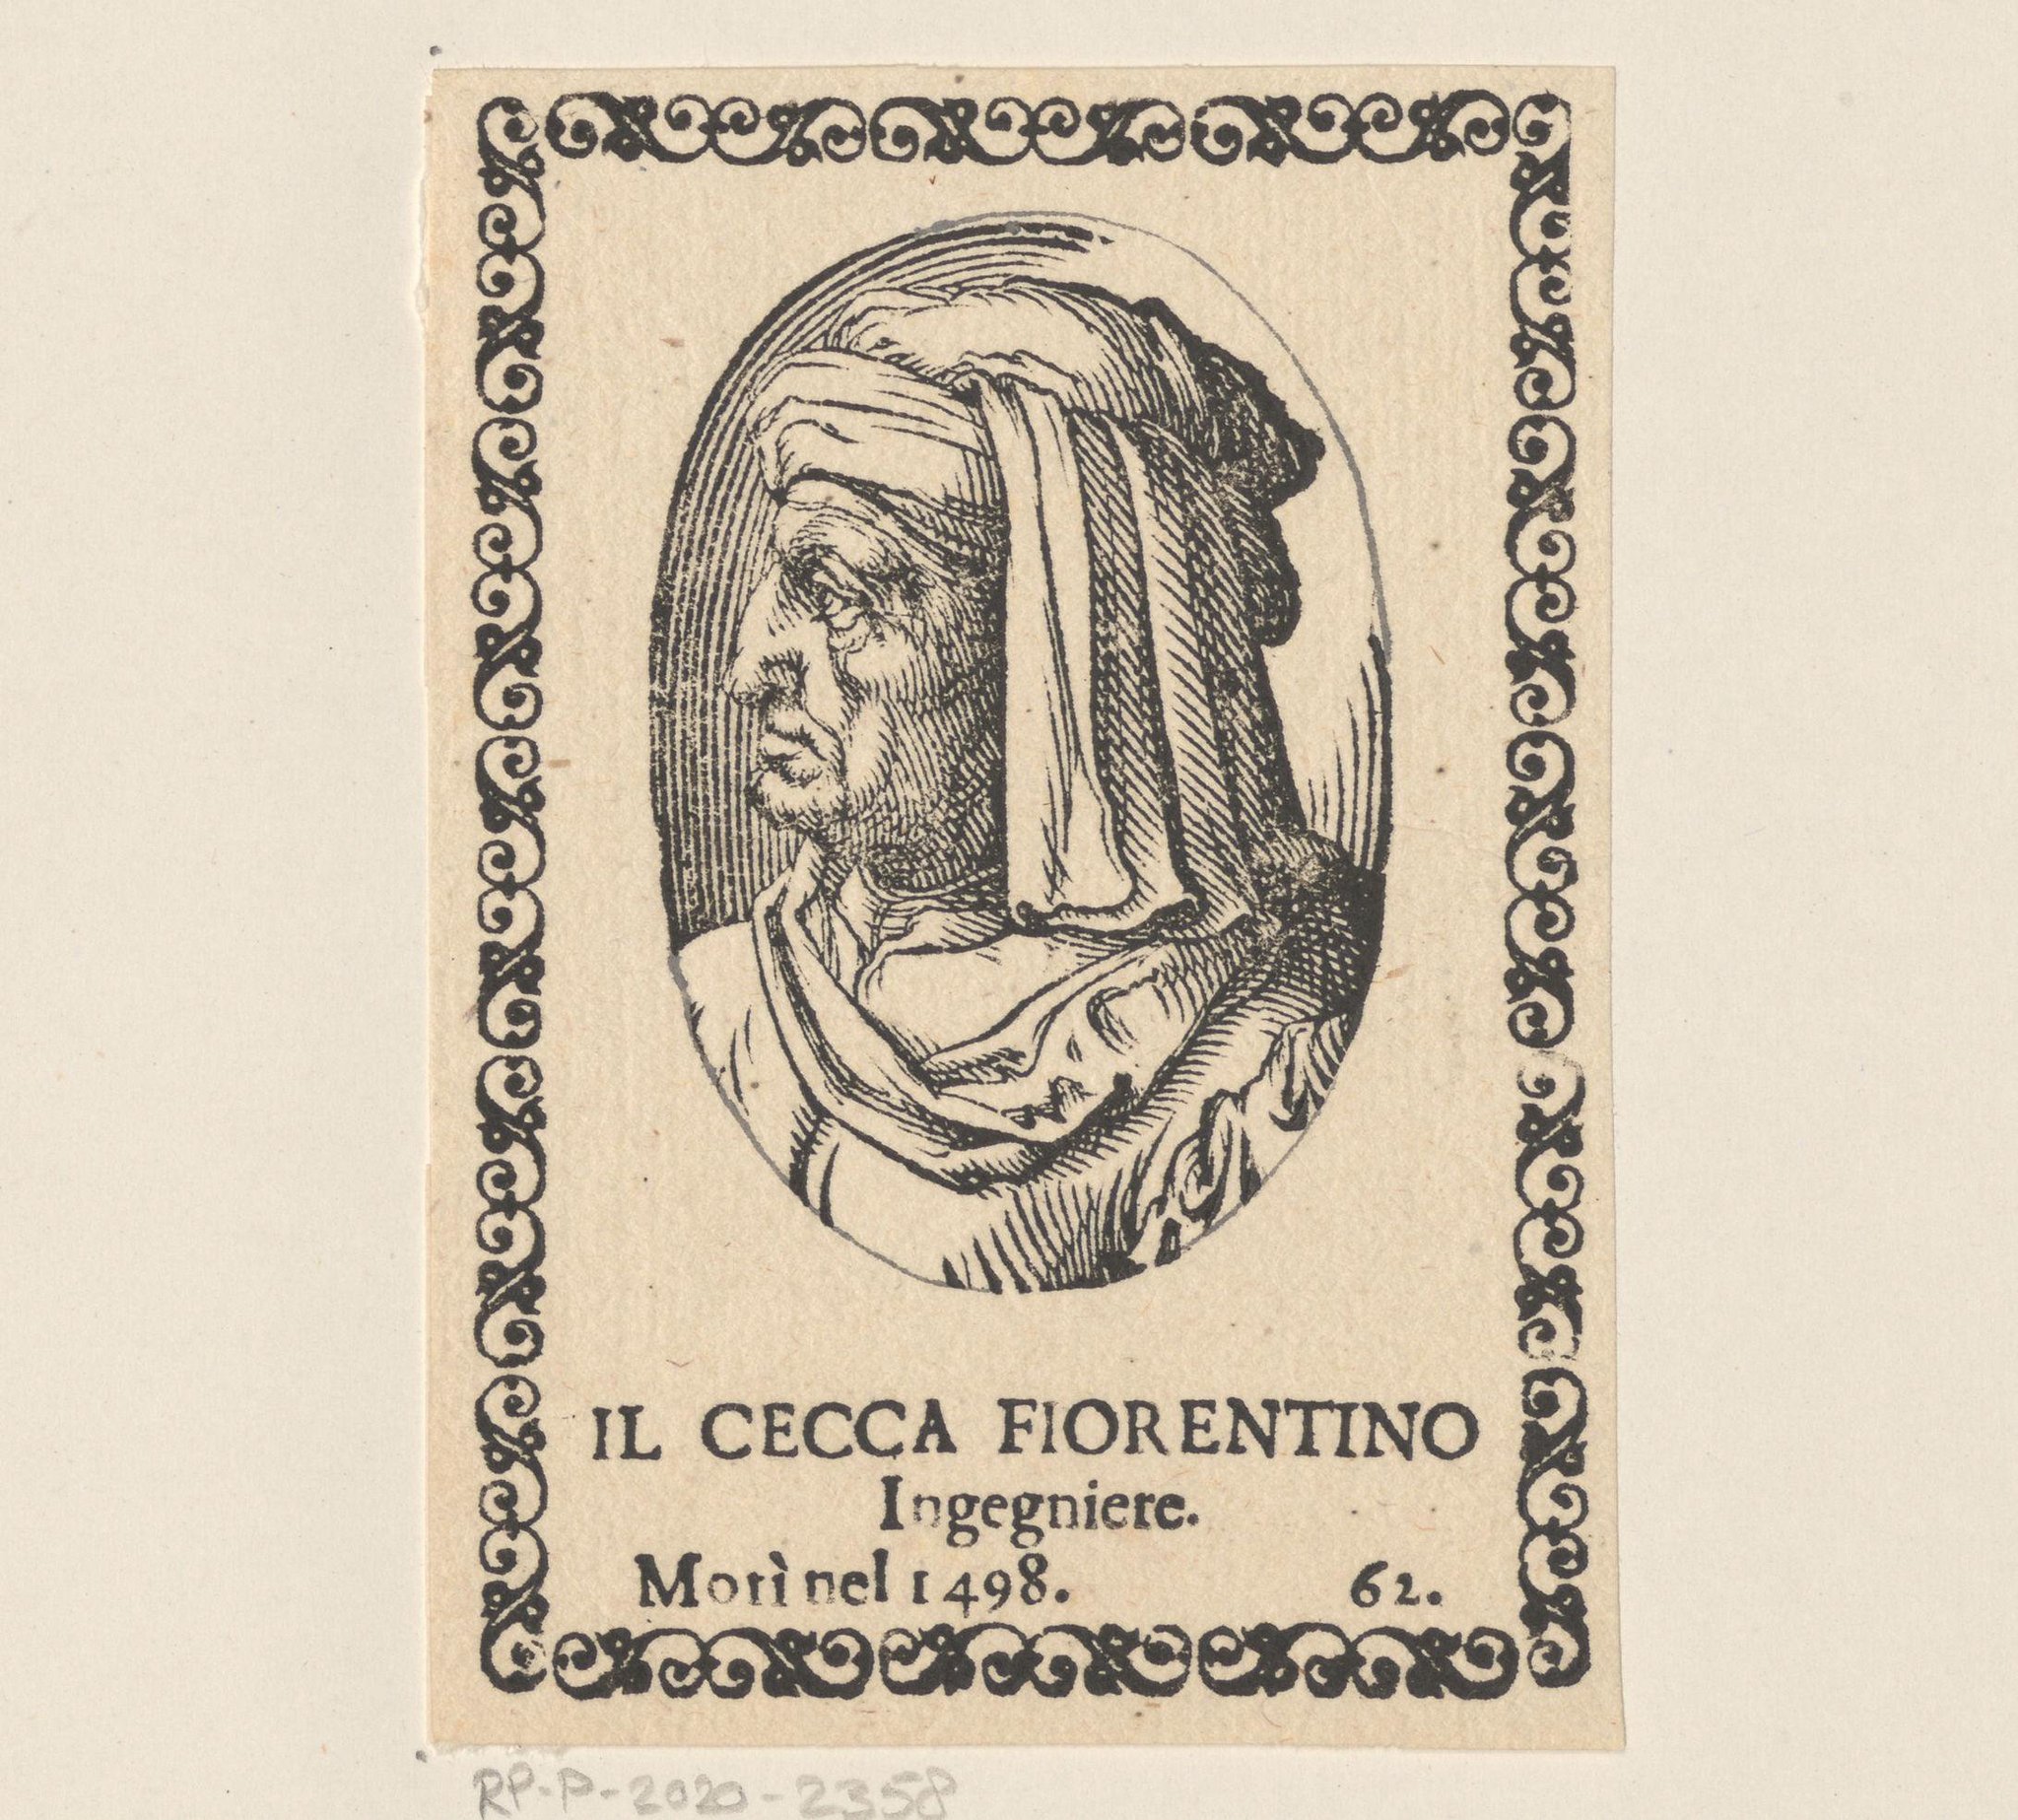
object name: print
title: Portret van Francesco Angeloni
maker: Anonymous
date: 1568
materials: paper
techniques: letterpress printing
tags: portrait, self-portrait of painter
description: Prent met andere omlijsting gebruikt in: Vasari, Giorgio. Le vite de’ più eccellenti pittori, scultori e architettori. Florence: Bernardo Giunti, 1568, dl. 2, p. 440.